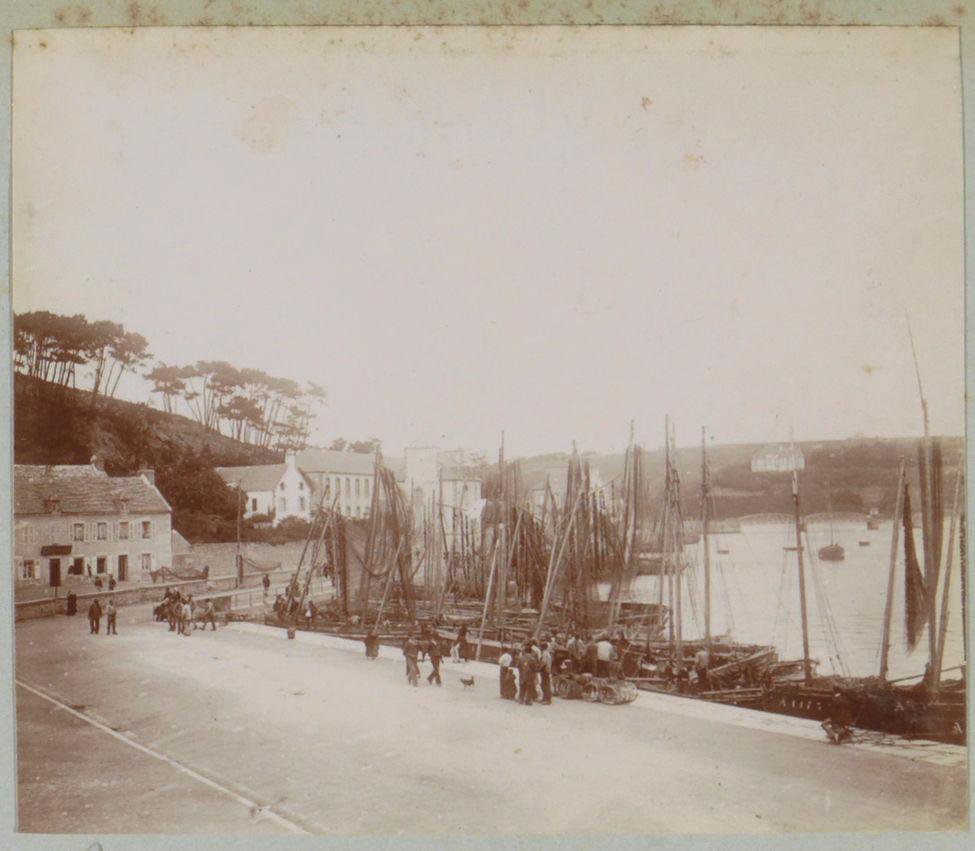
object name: photograph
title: Gezicht op een kade en de haven van Audierne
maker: delizy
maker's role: manufacturer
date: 1901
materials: paper, photographic support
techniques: gelatin silver print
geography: audierne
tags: sailing-ship, sailing-boat, harbour (+ view ~ vehicle, ship, etc.), pier, quay, wharf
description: Onderdeel van Fotoalbum van een Franse amateurfotograaf met opnames van uitstapjes in Frankrijk, Spanje, België, Luxemburg en Nederland, de eerste automobielen en autoraces.